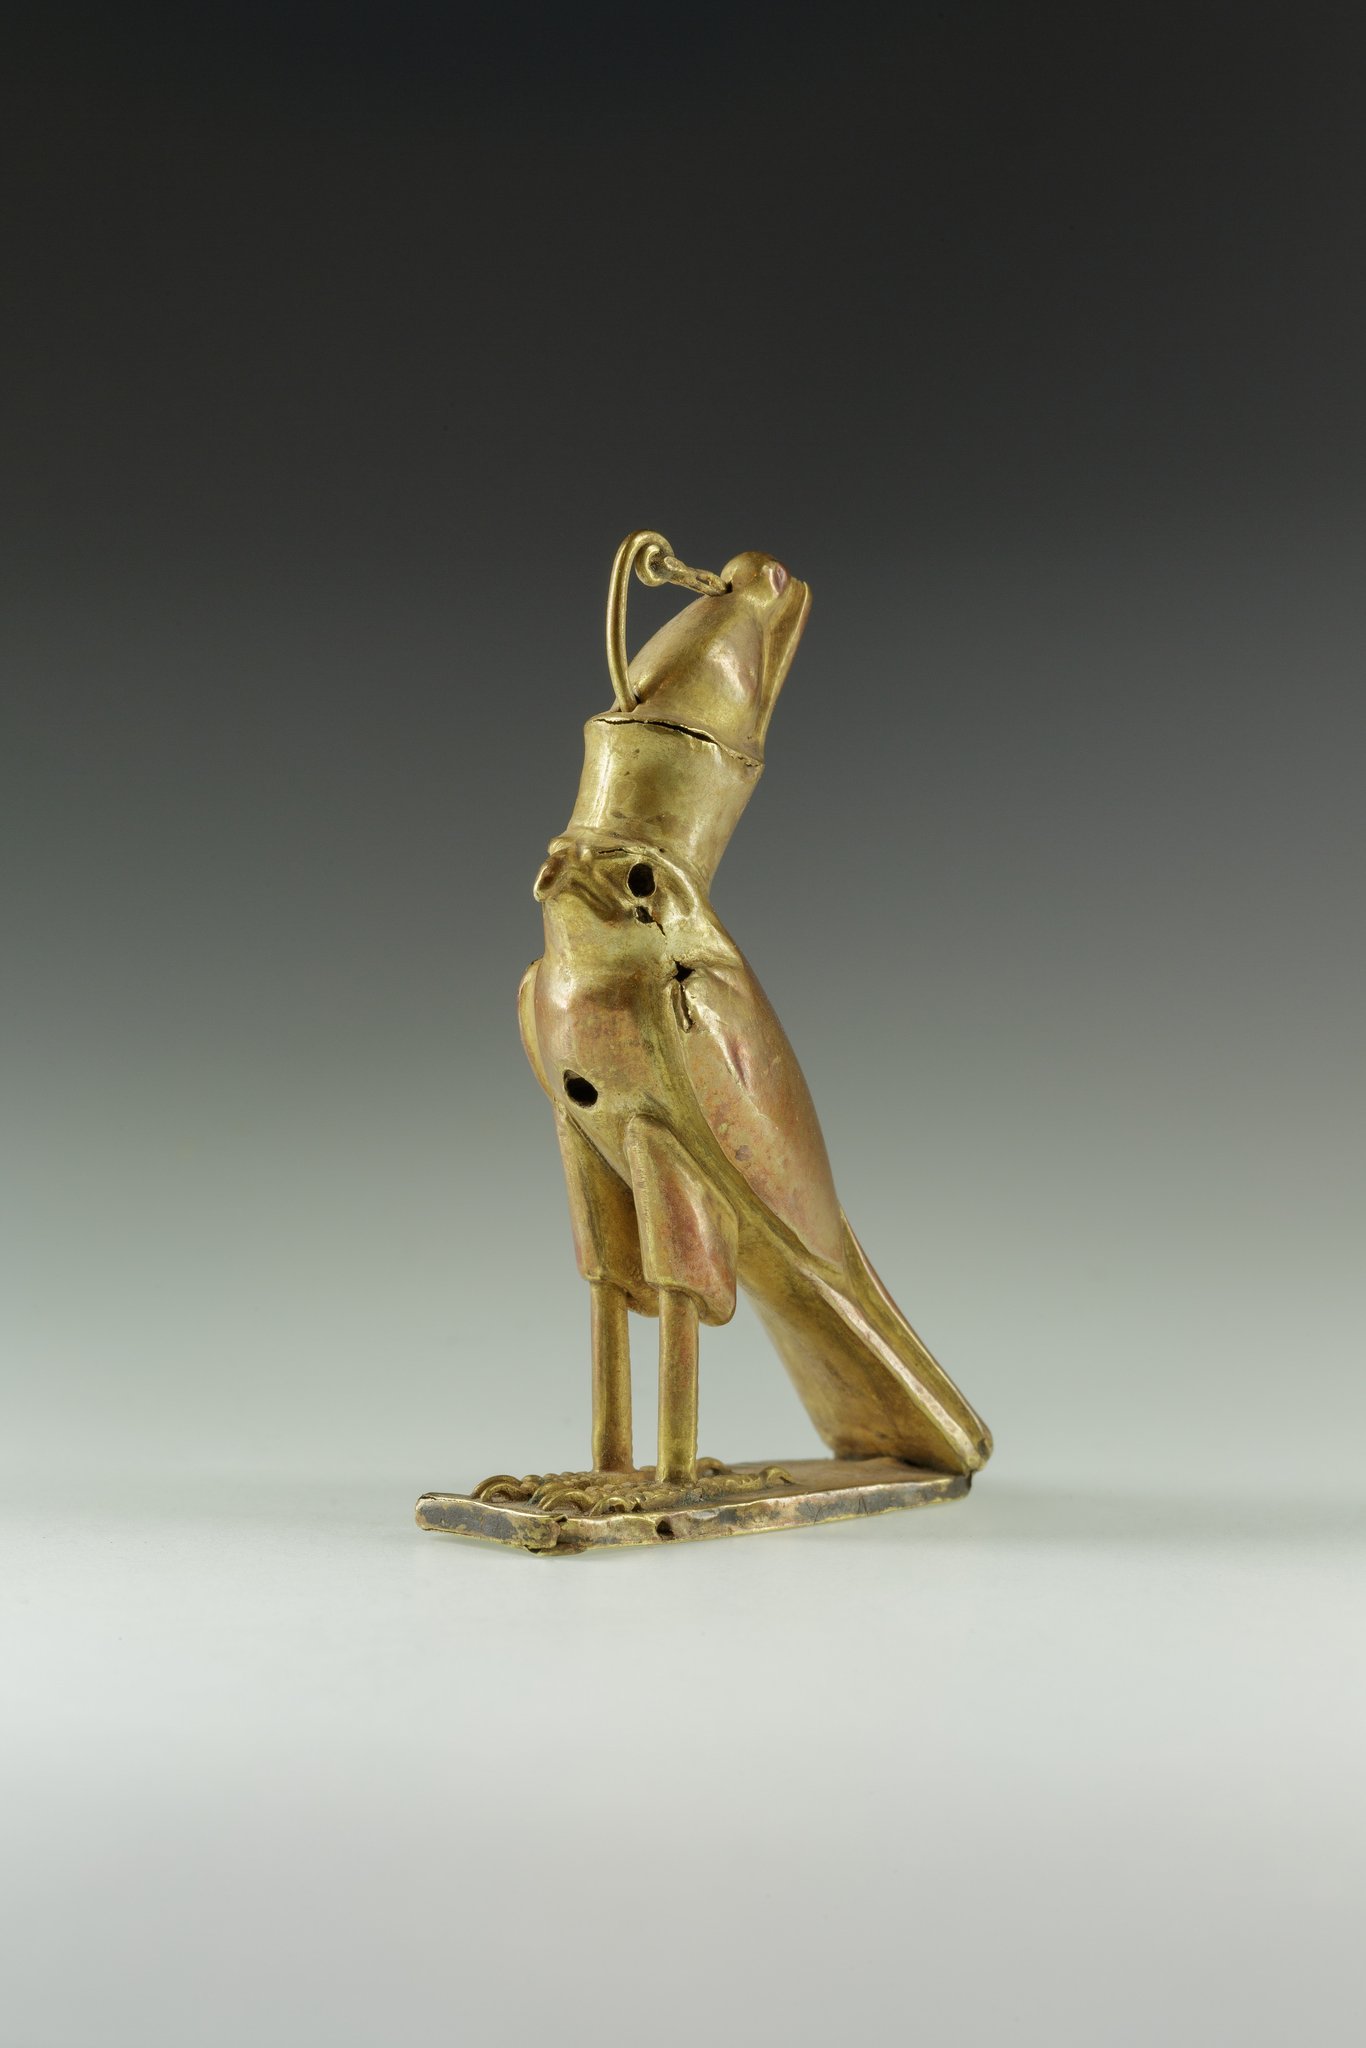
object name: amulet, horus falcon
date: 664-332 BCE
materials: gold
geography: egypt